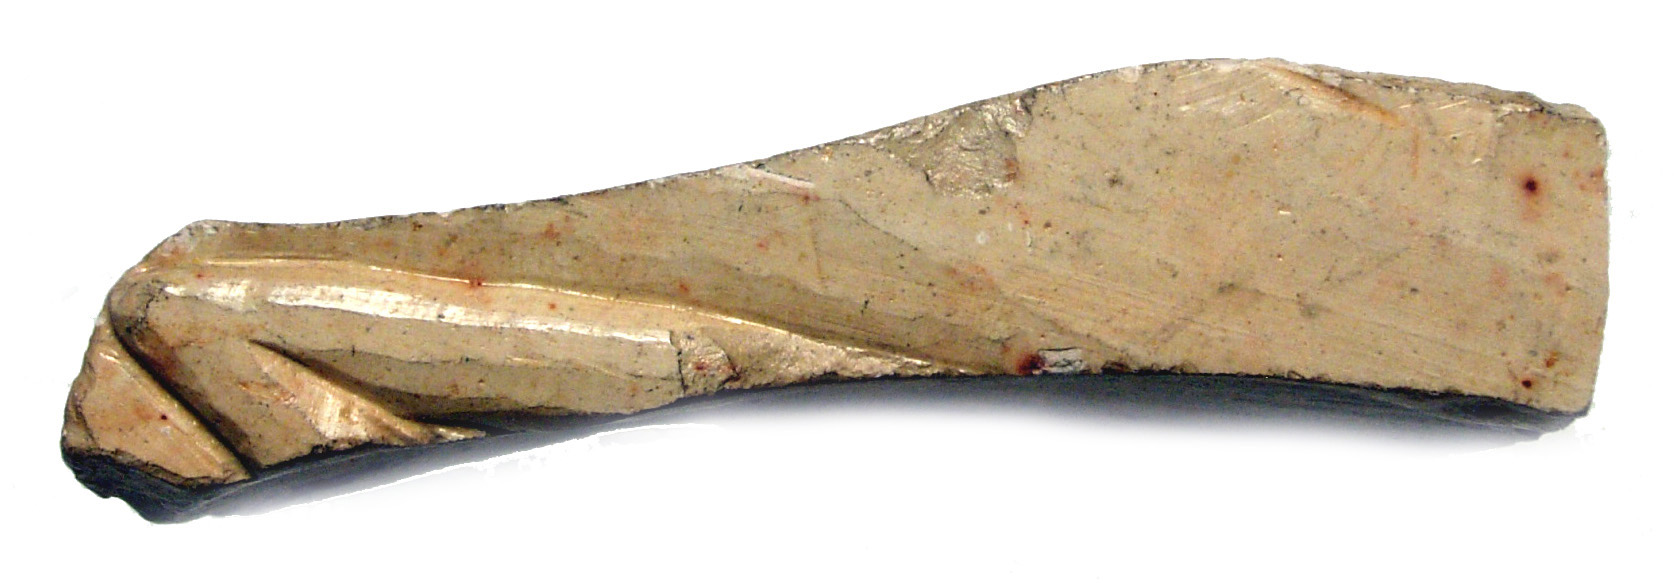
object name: relief, tomb of nespekashuty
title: Raised relief fragment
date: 664-610 BCE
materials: limestone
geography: egypt